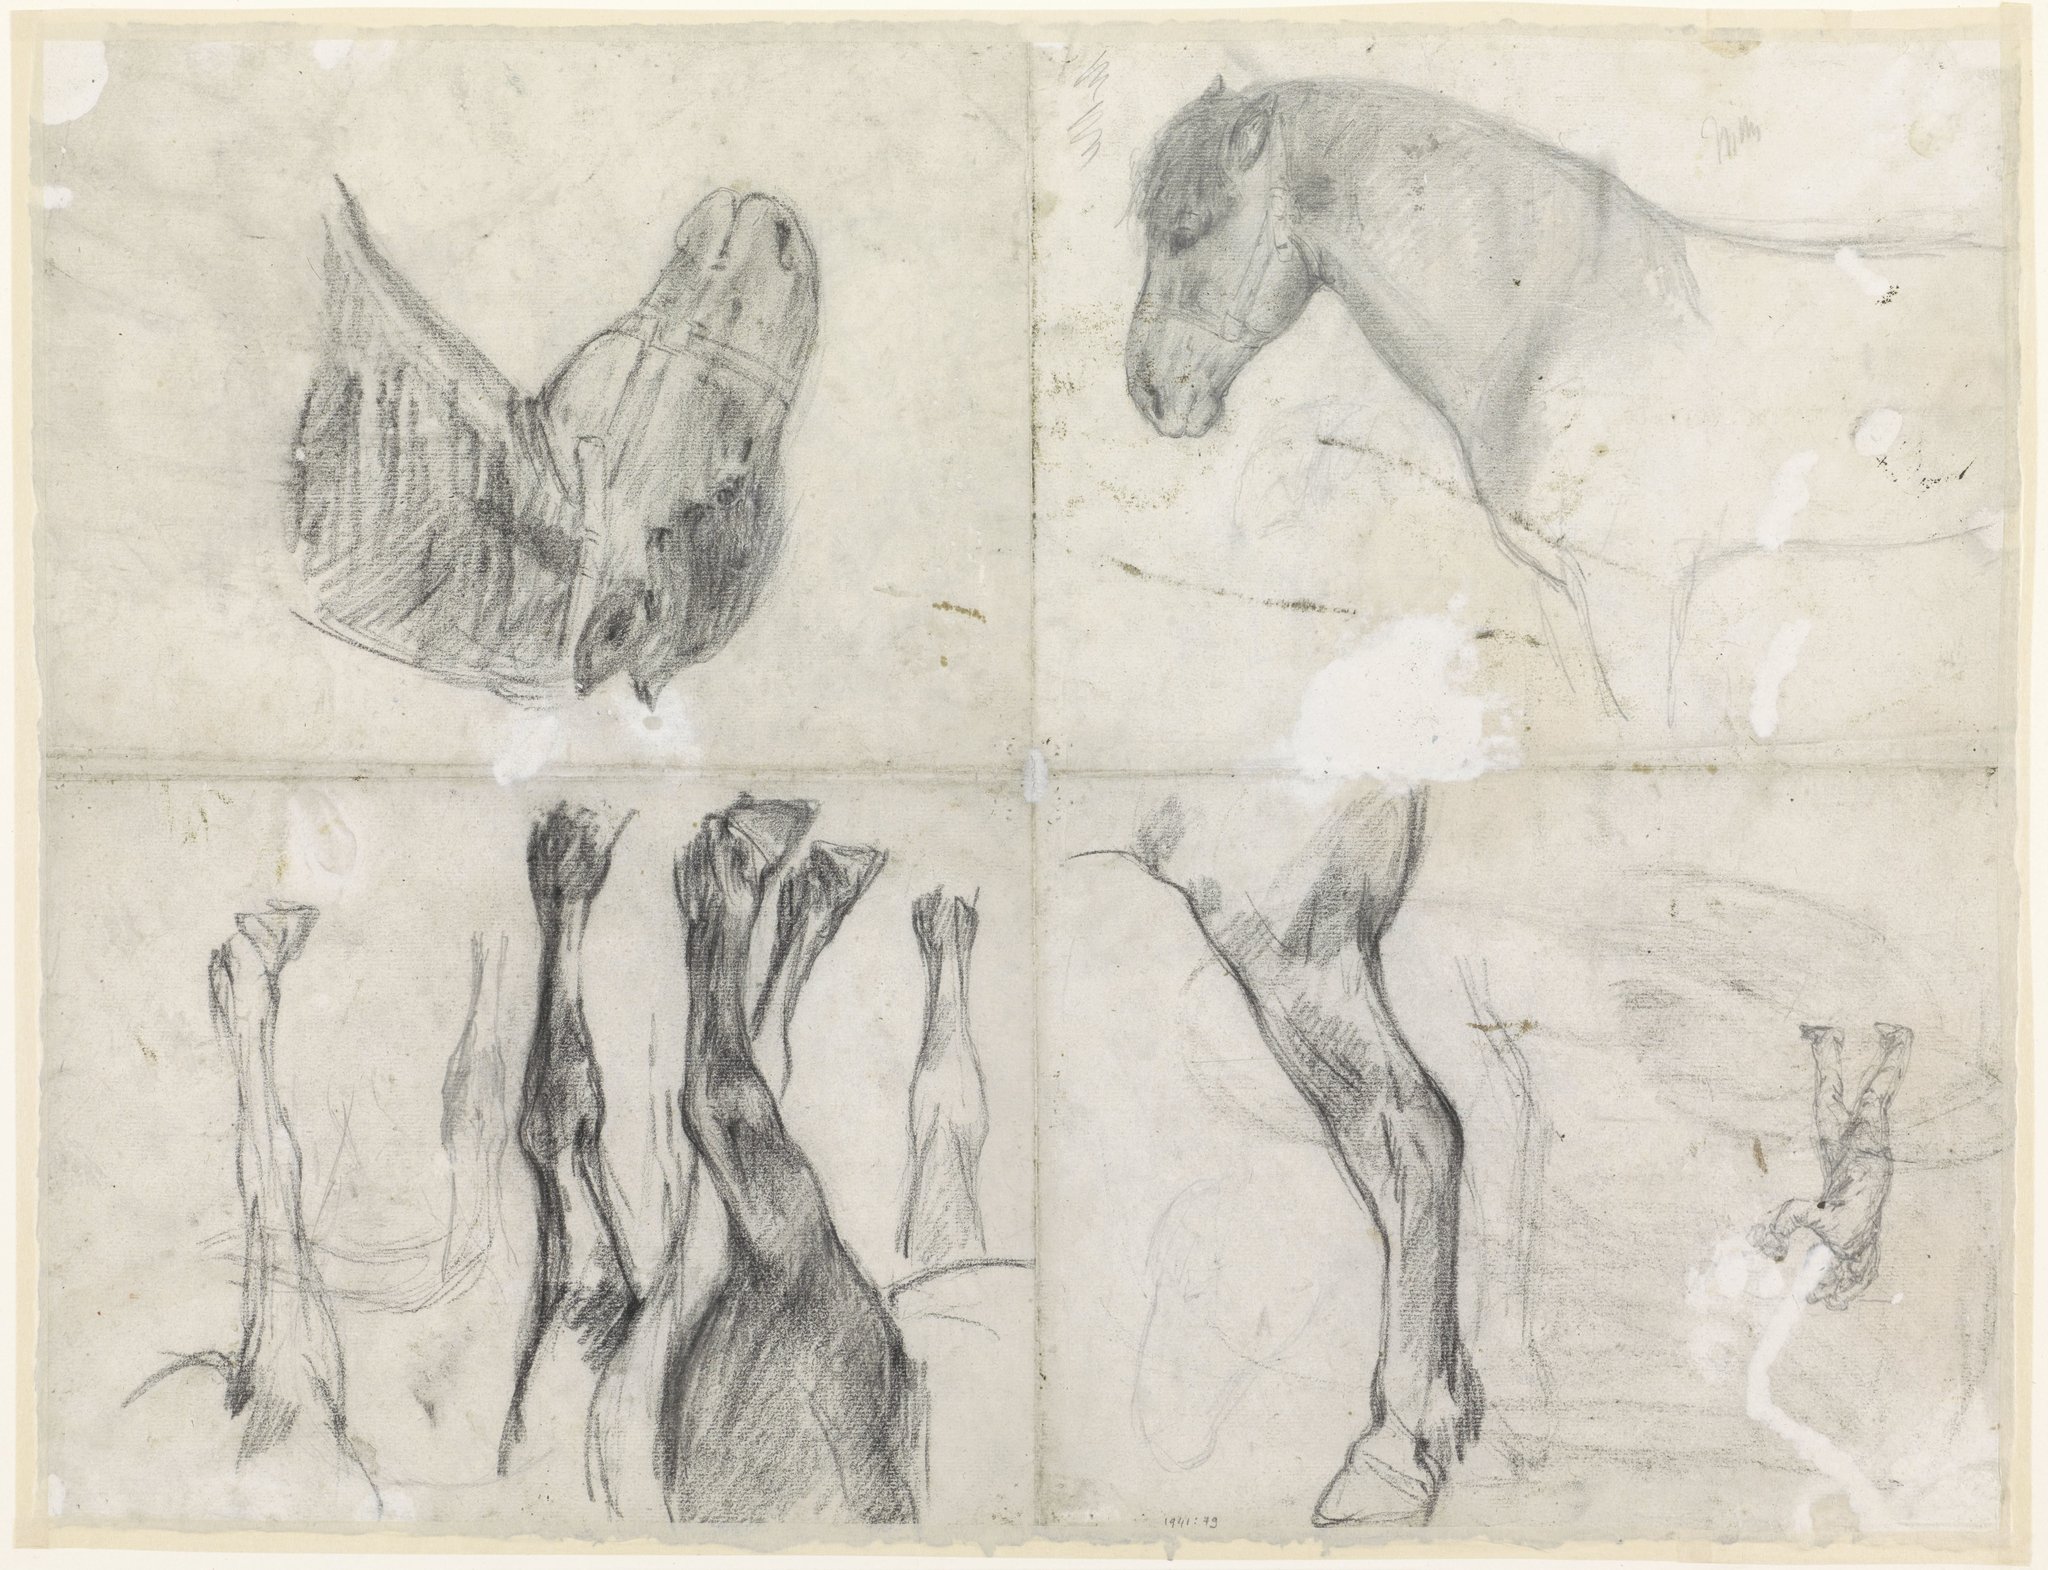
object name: drawing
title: Schetsblad met studies van een paard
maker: jan kuyper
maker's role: draughtsman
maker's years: 1845-1912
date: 1855-1912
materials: chalk, paper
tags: horse, male sex; man